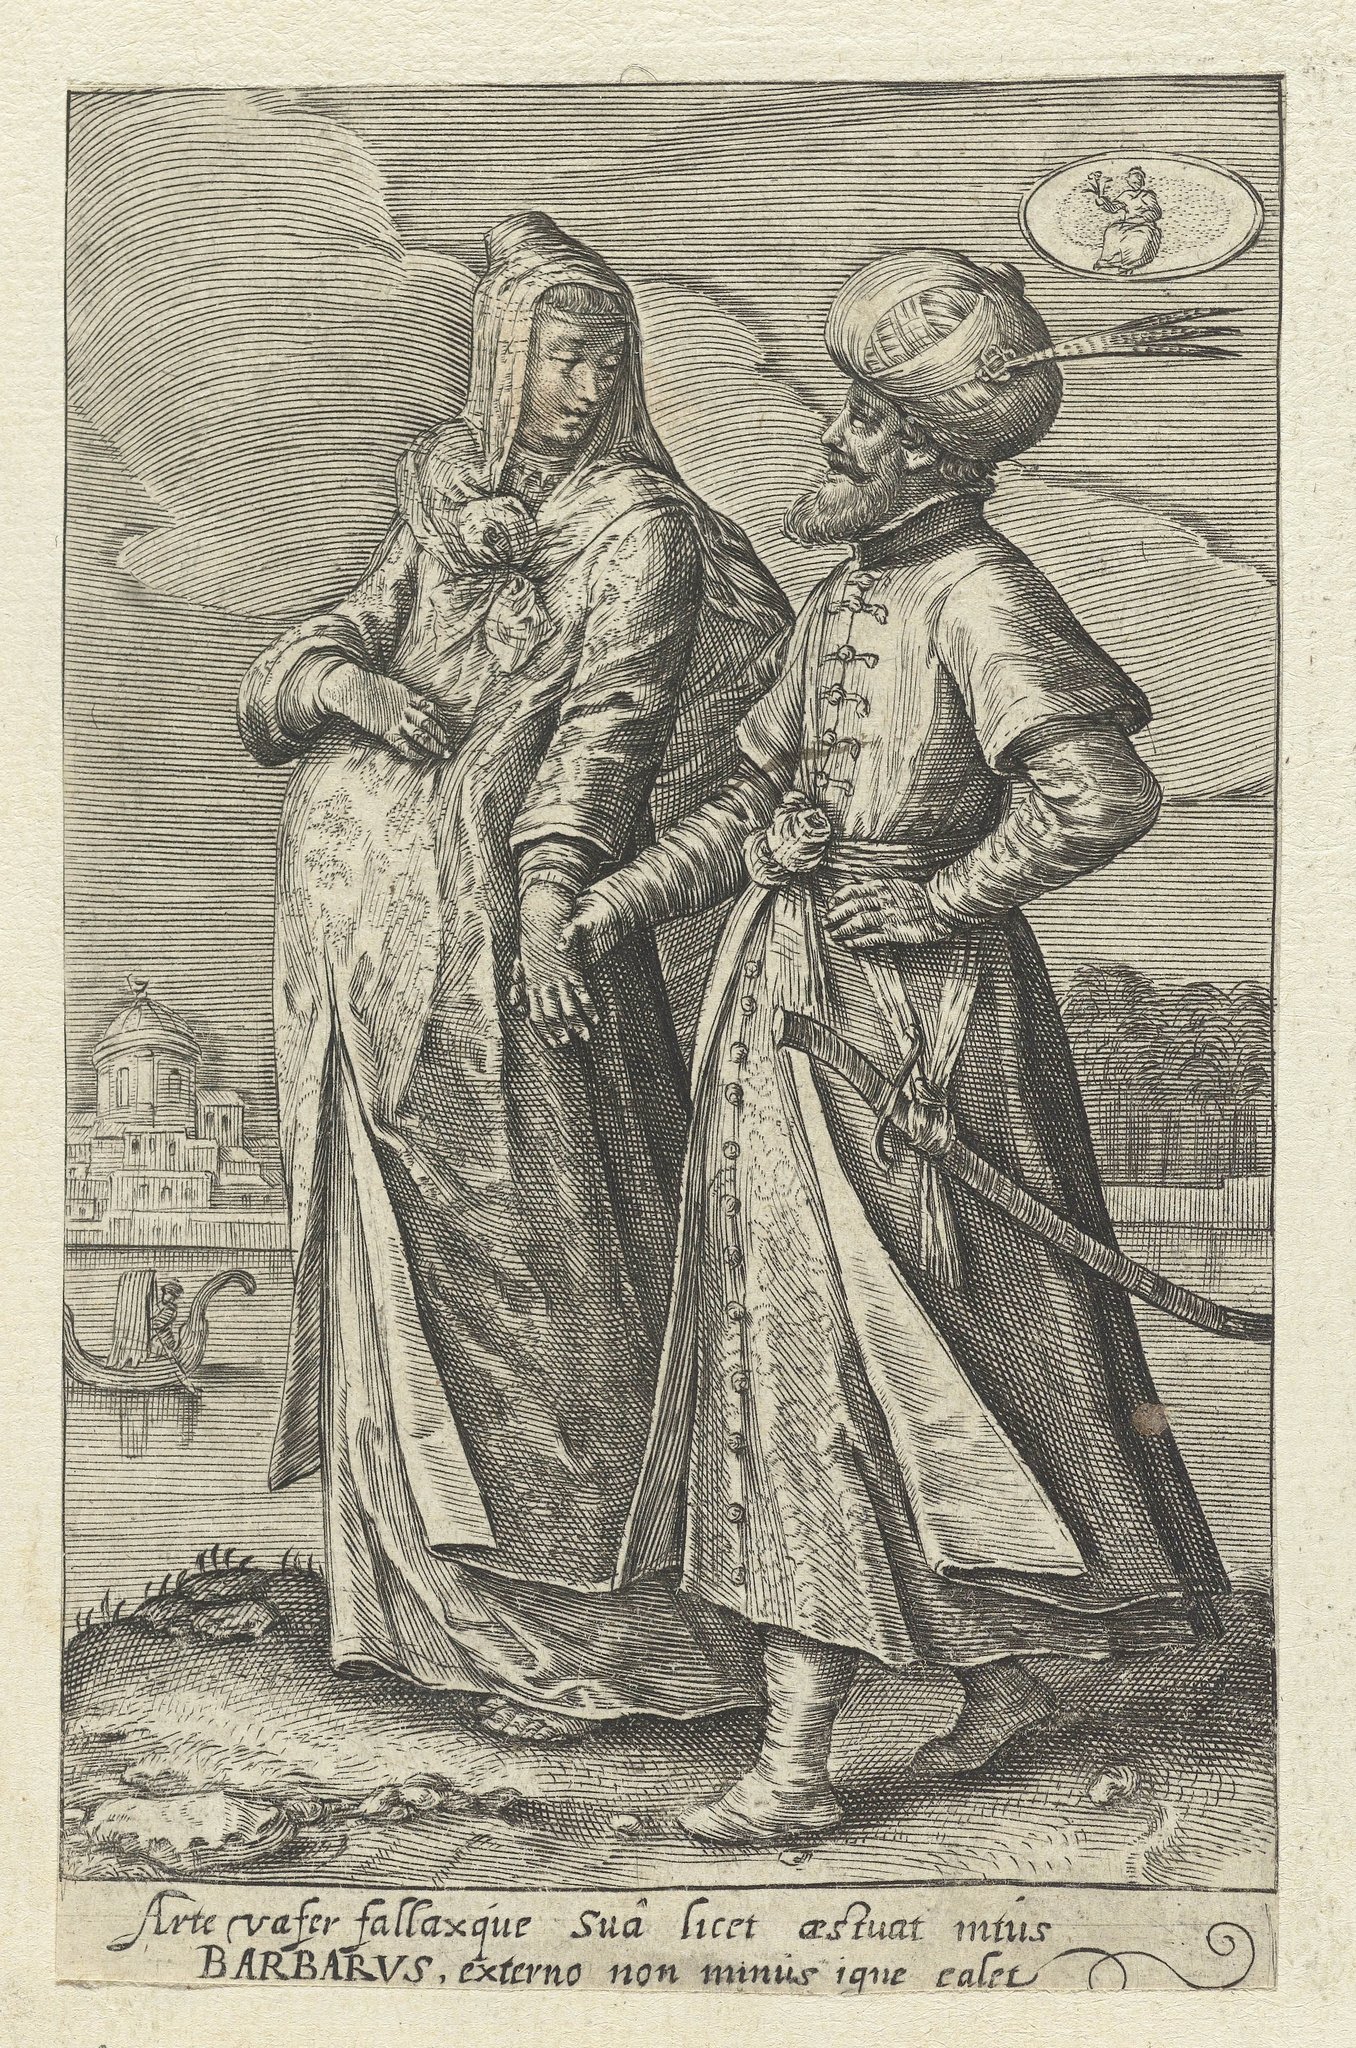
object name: costume print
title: De twaalf maanden met paren in kostuums uit verschillende landen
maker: crispijn van de passe (ii)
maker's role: draughtsman, print maker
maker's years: 1594-1670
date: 1604-1670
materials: paper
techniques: engraving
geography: northern netherlands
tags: virgo (zodiacal sign of august), asiatic races and peoples: turks, veil (+ women's clothes), coat (+ men's clothes), clothes, costume (+ women's clothes), dress, gown (+ women's clothes), head-gear: turban, shoes, sandals (+ men's clothes), clothes, costume (+ men's clothes), pregnant woman, august ~ other concepts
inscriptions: caption: ‘Arte vafer fallaxque suâ licet aestuat intus / BARBARVS, externo non minus igne calet’, inscription: ‘110’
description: Man en zwangere vrouw, gekleed in Turkse dracht, op de oever van een rivier. Op de achtergrond een stadsgezicht. Rechtsboven het teken van Maagd. In de marge een tweeregelig onderschrift in het Latijn over de sluwheid van 'de Barbaar' die ook voor de vrouw in vuur en vlam kan staan. Prent uit een serie met de twaalf maanden weergegeven door tekens van de dierenriem en paren die kleding uit verschillende landen dragen.